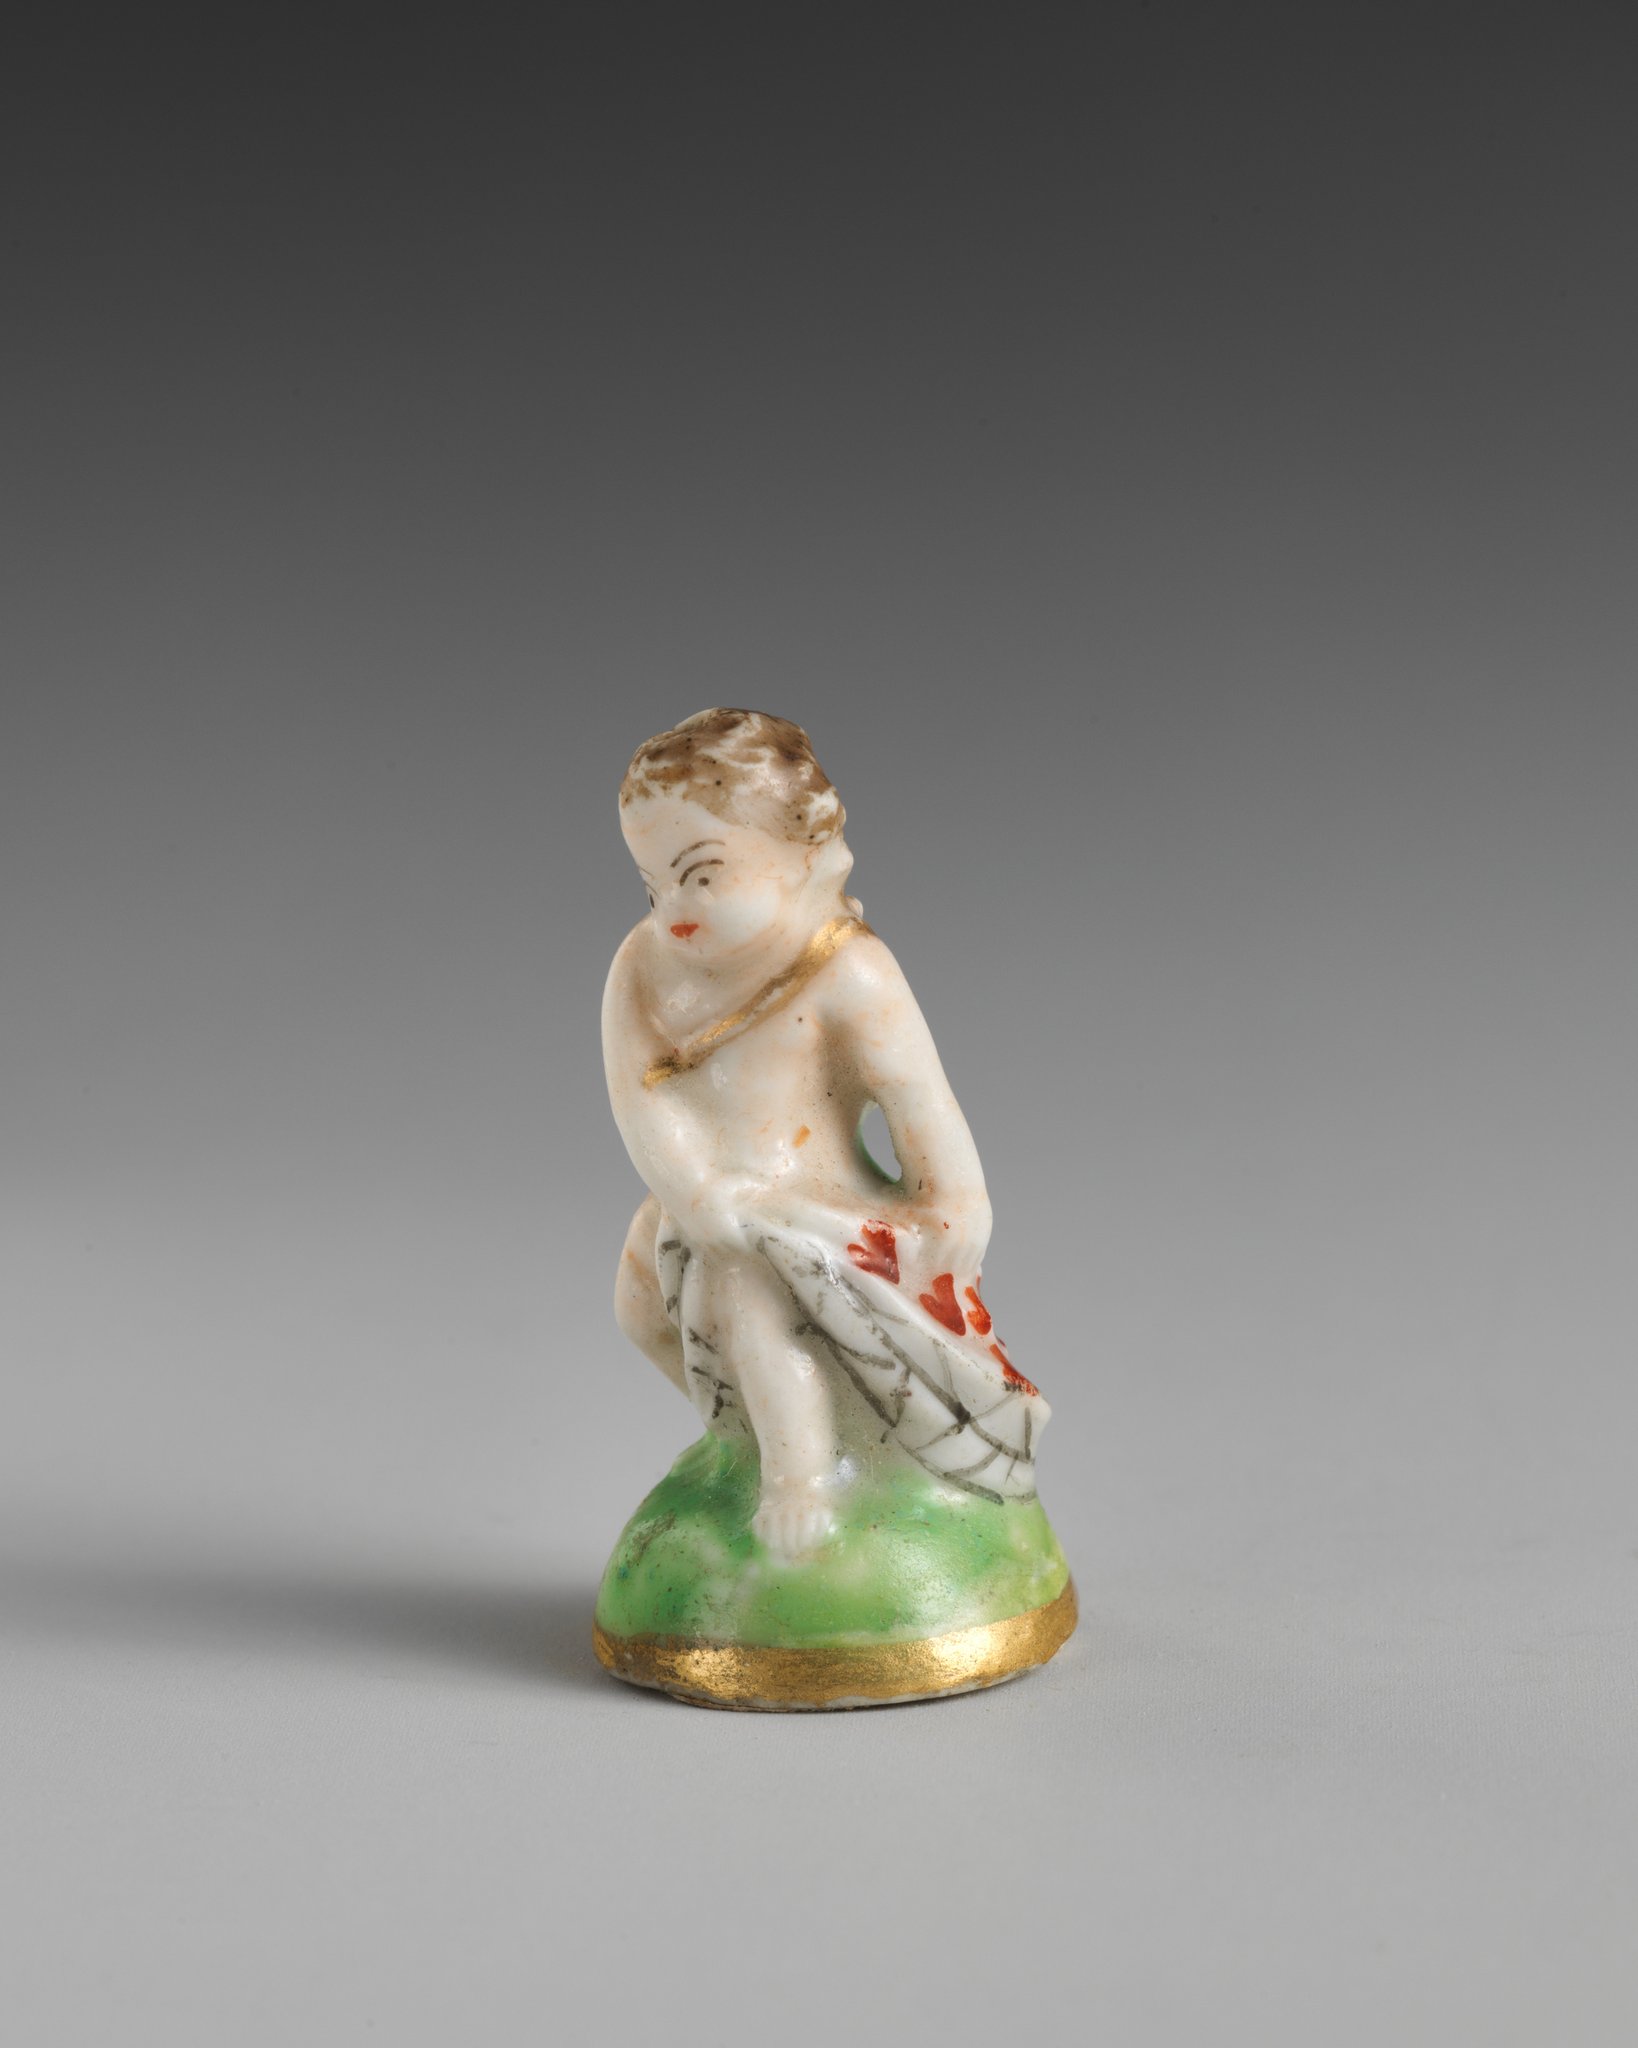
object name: seal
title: Miniature seal in the form of Cupid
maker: derby porcelain manufactory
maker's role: factory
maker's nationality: british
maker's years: 1751-1785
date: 1770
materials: soft paste porcelain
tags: cupid